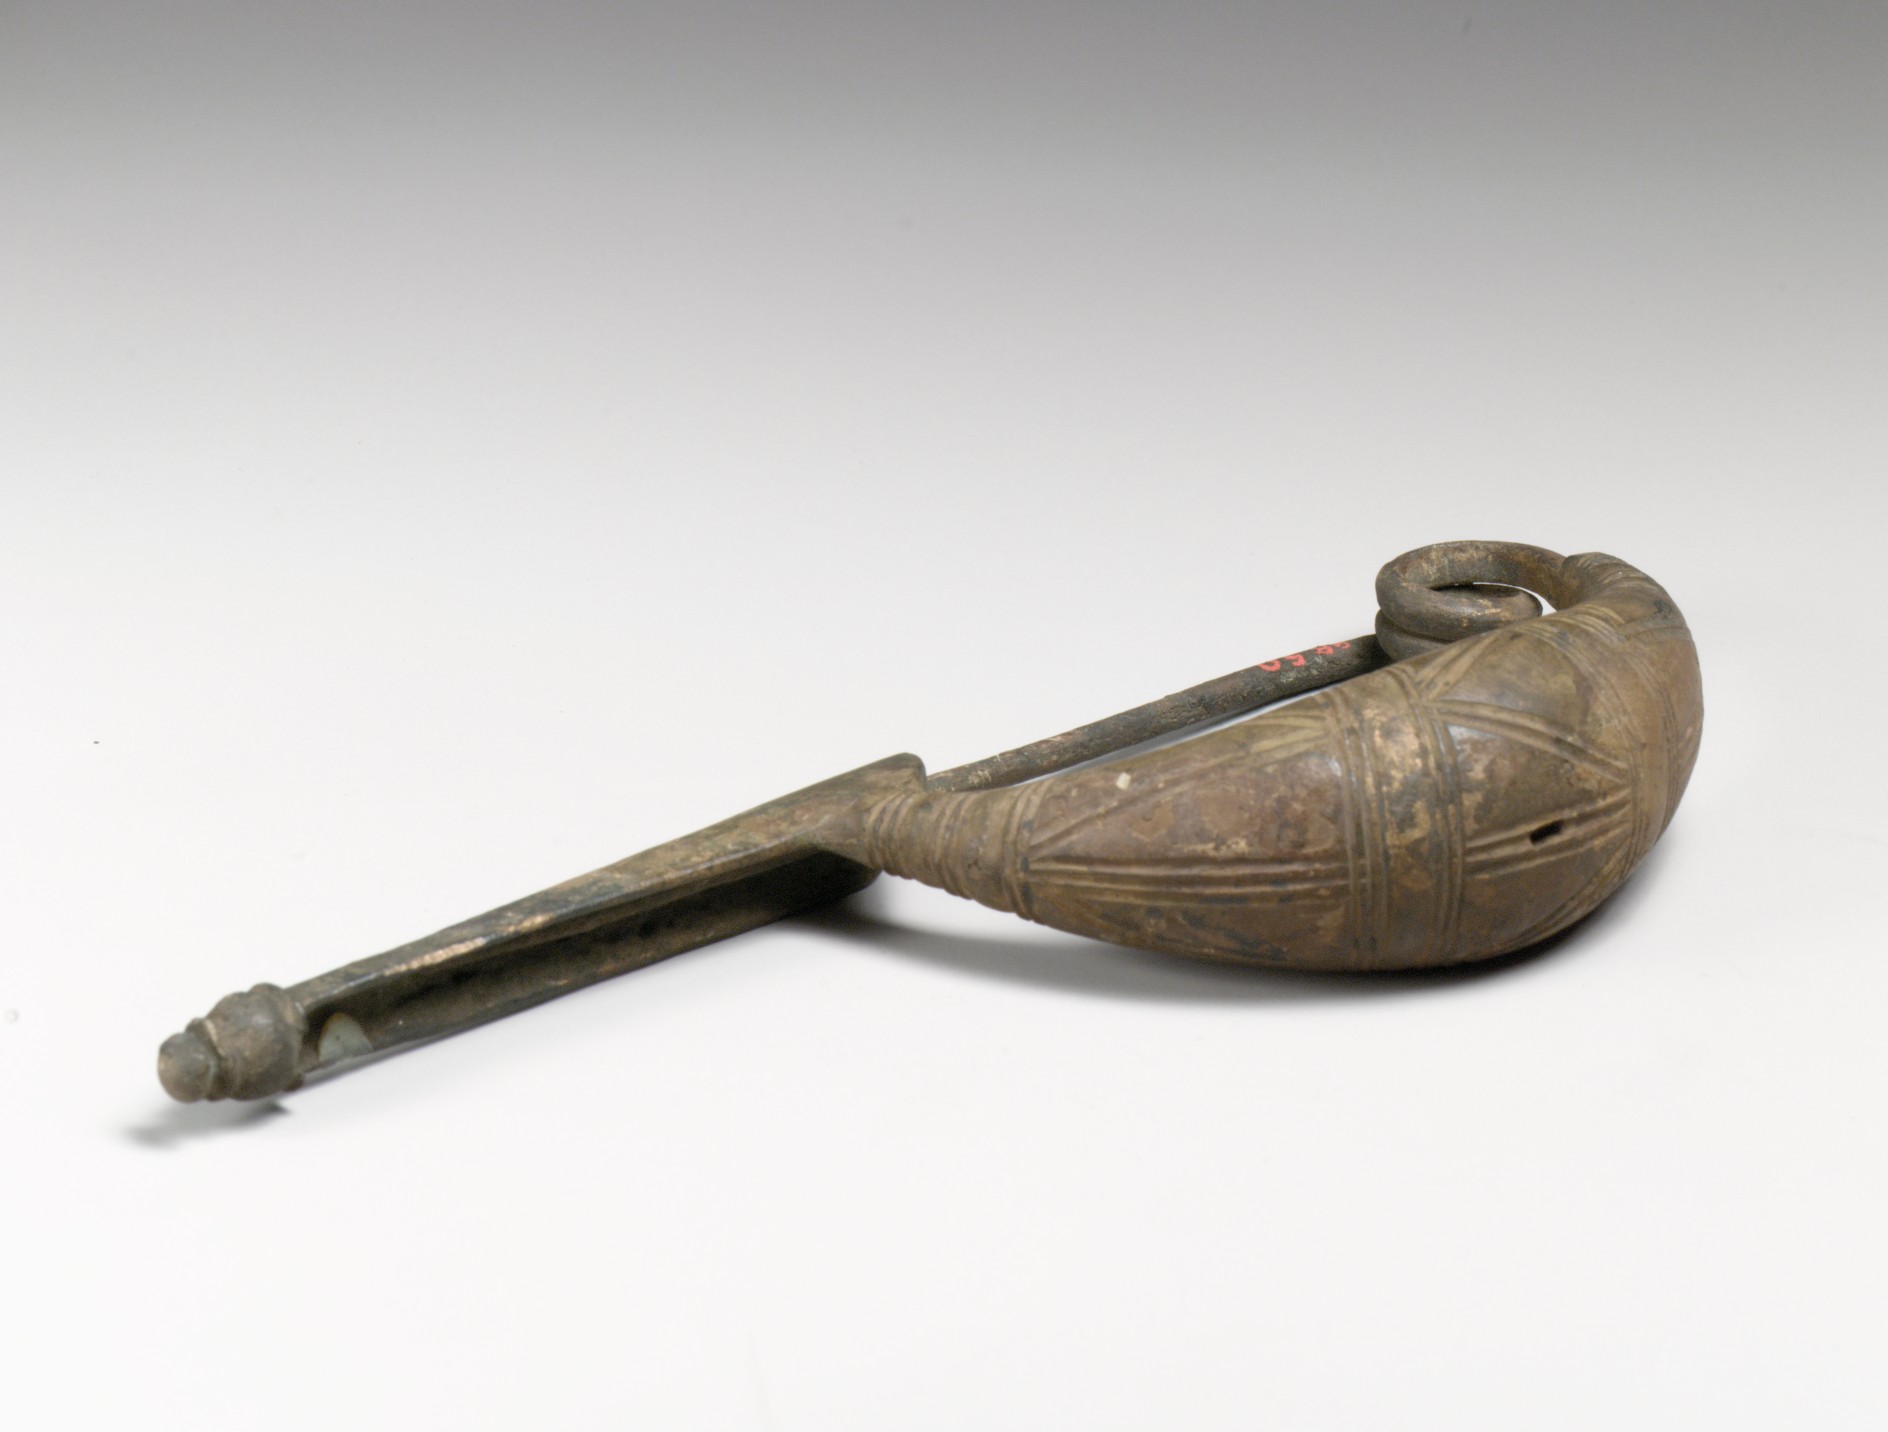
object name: fibula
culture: italic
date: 600-301 BCE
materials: bronze